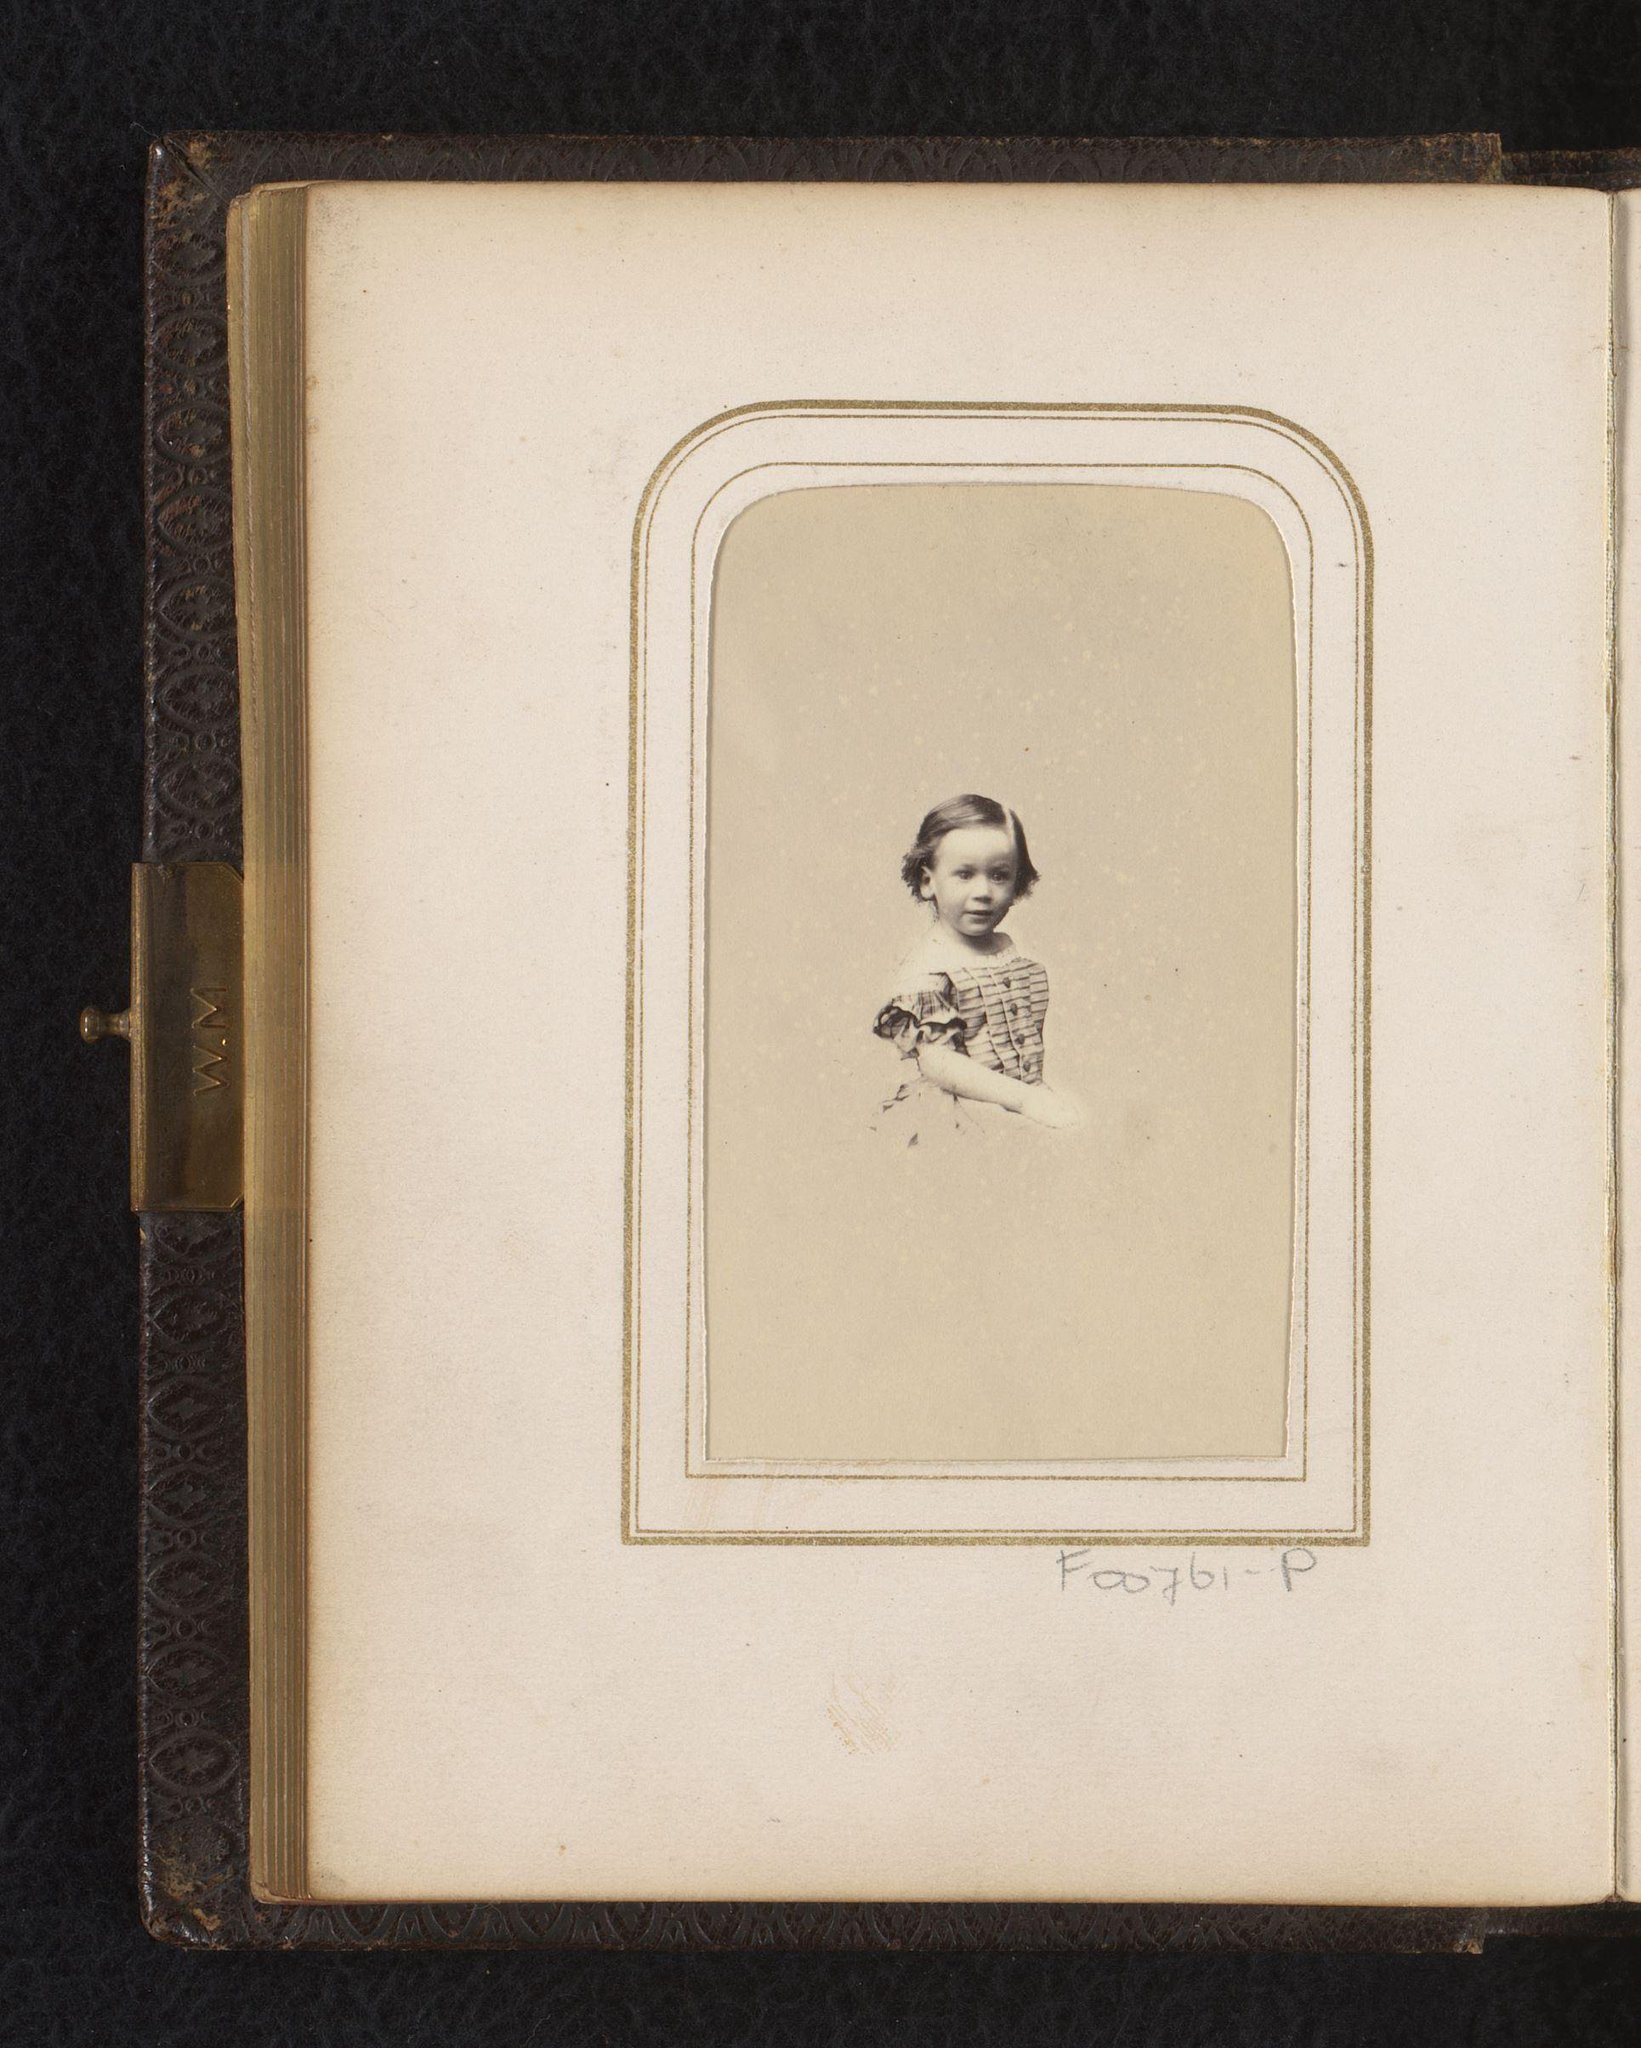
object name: carte de visite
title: Portret van een meisje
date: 1860-1880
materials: cardboard, photographic support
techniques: albumen print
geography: nottingham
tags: girl (child between toddler and youth)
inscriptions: inscription: ‘A.W. & H. Cox/ Portrait & Landscape Photographers/ St. James Street/ Nottingham (...)’